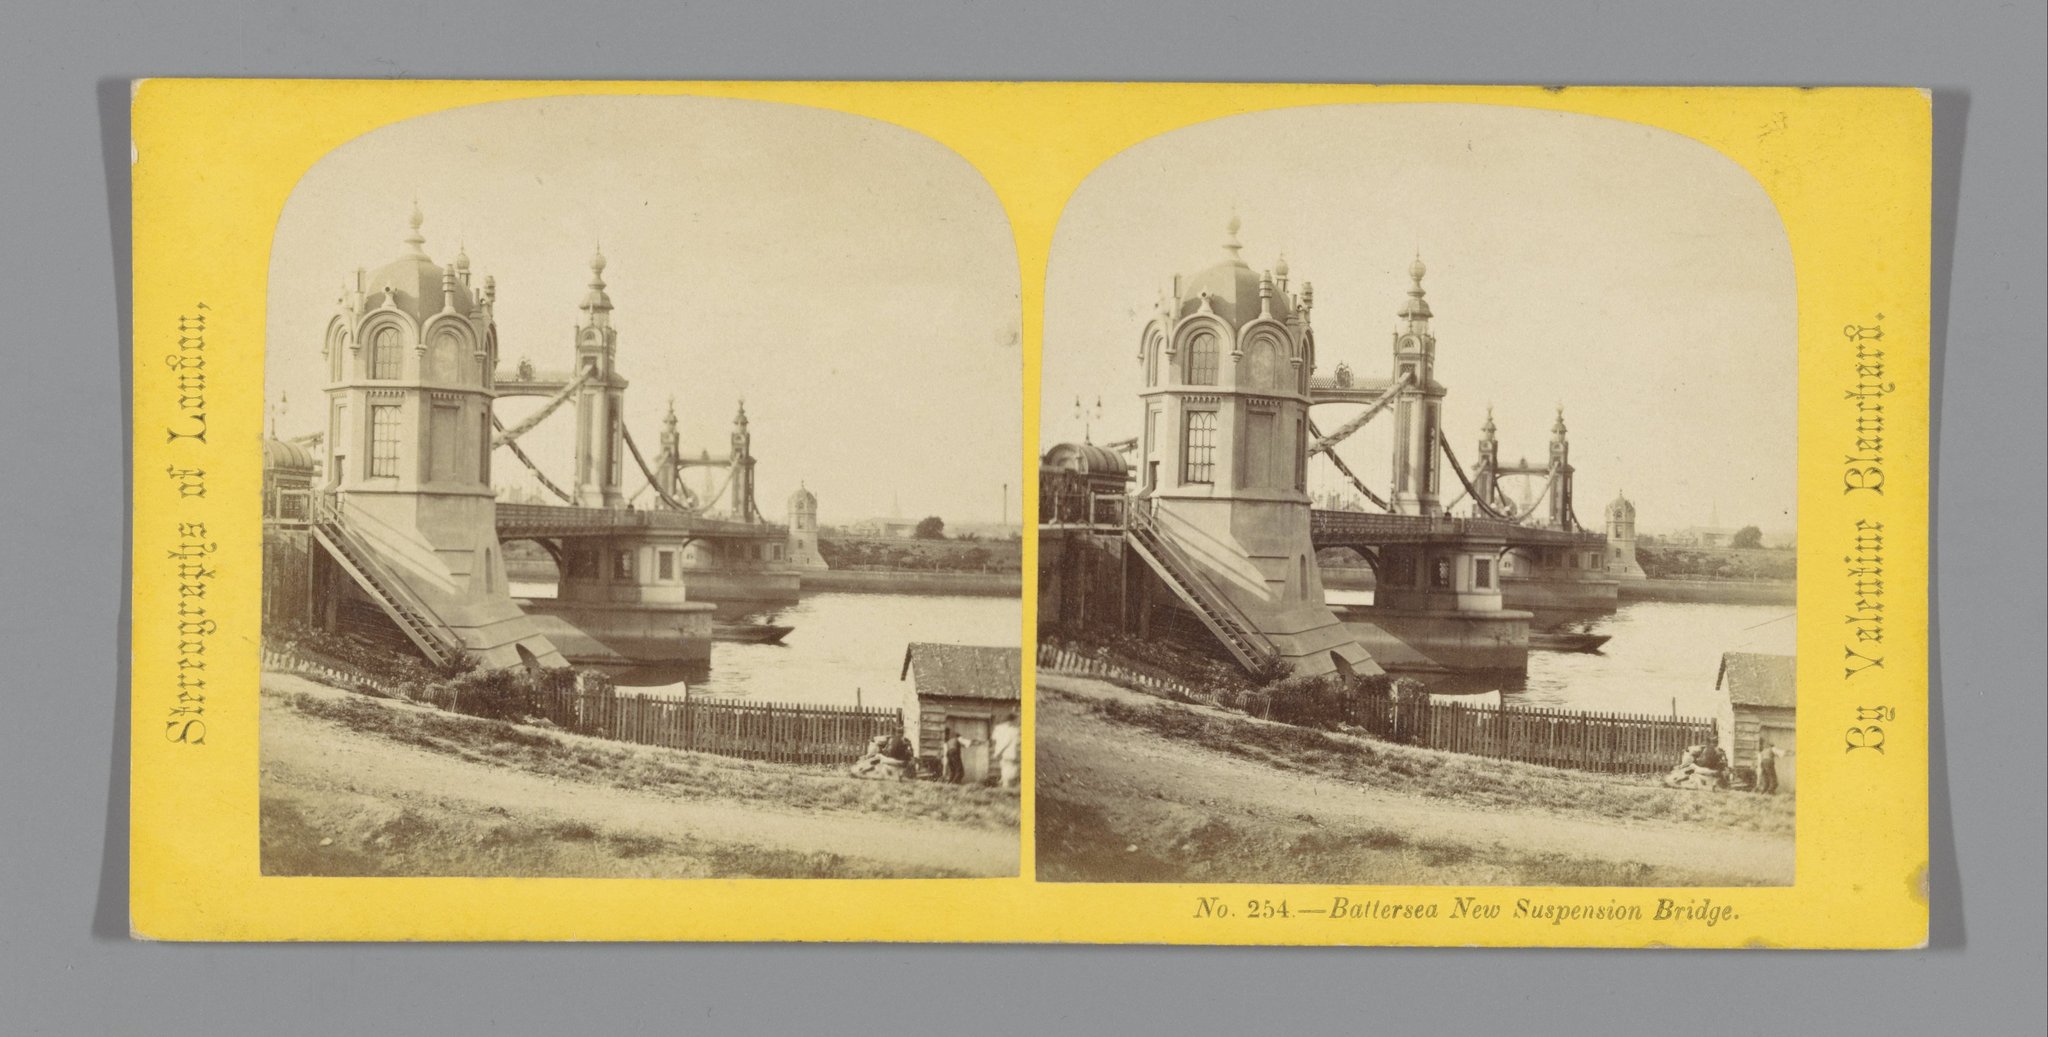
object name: stereograph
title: Battersea New Suspension Bridge.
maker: valentine blanchard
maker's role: fotograaf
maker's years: 1831-1901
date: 1857-1880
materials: cardboard, photographic support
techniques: albumen print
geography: chelsea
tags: suspension bridge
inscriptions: inscription: ‘Stereographs of London, By Valentine Blanchard.’, number: ‘No. 254.’